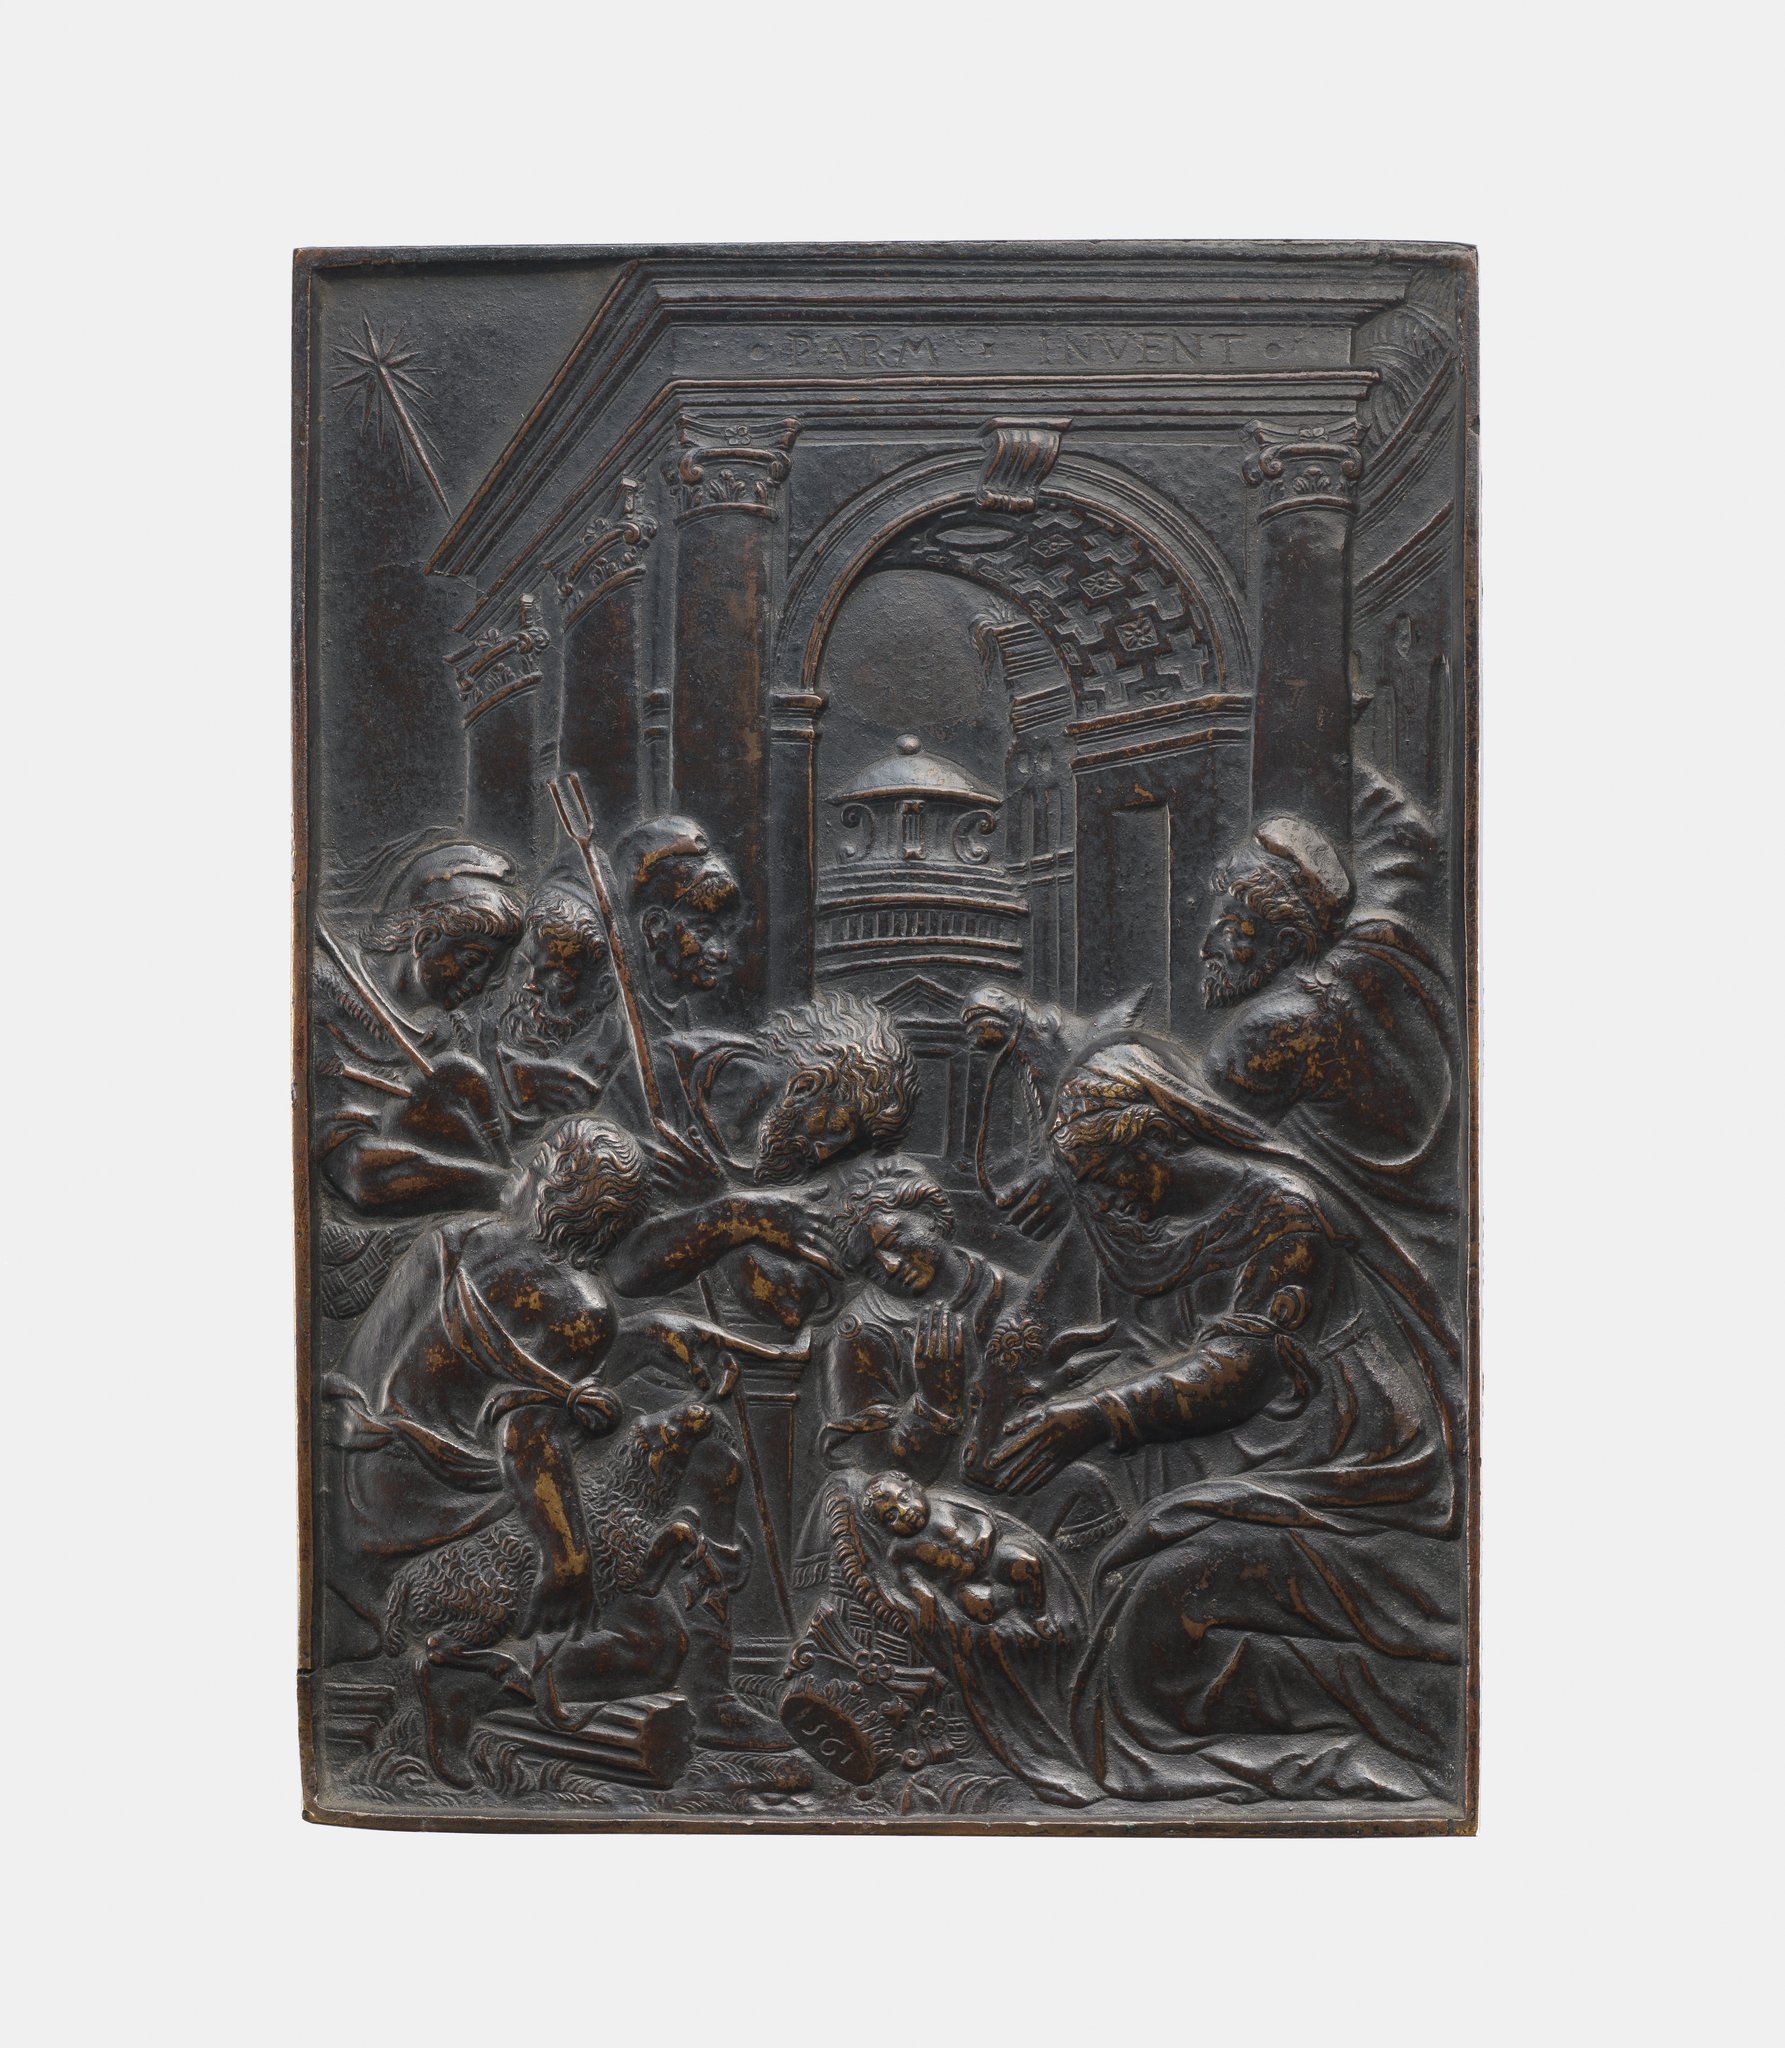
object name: plaquette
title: Adoration of the Shepherds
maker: gian federigo bonzagna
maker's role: artist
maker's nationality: italian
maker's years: 1507-1588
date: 1561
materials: bronze